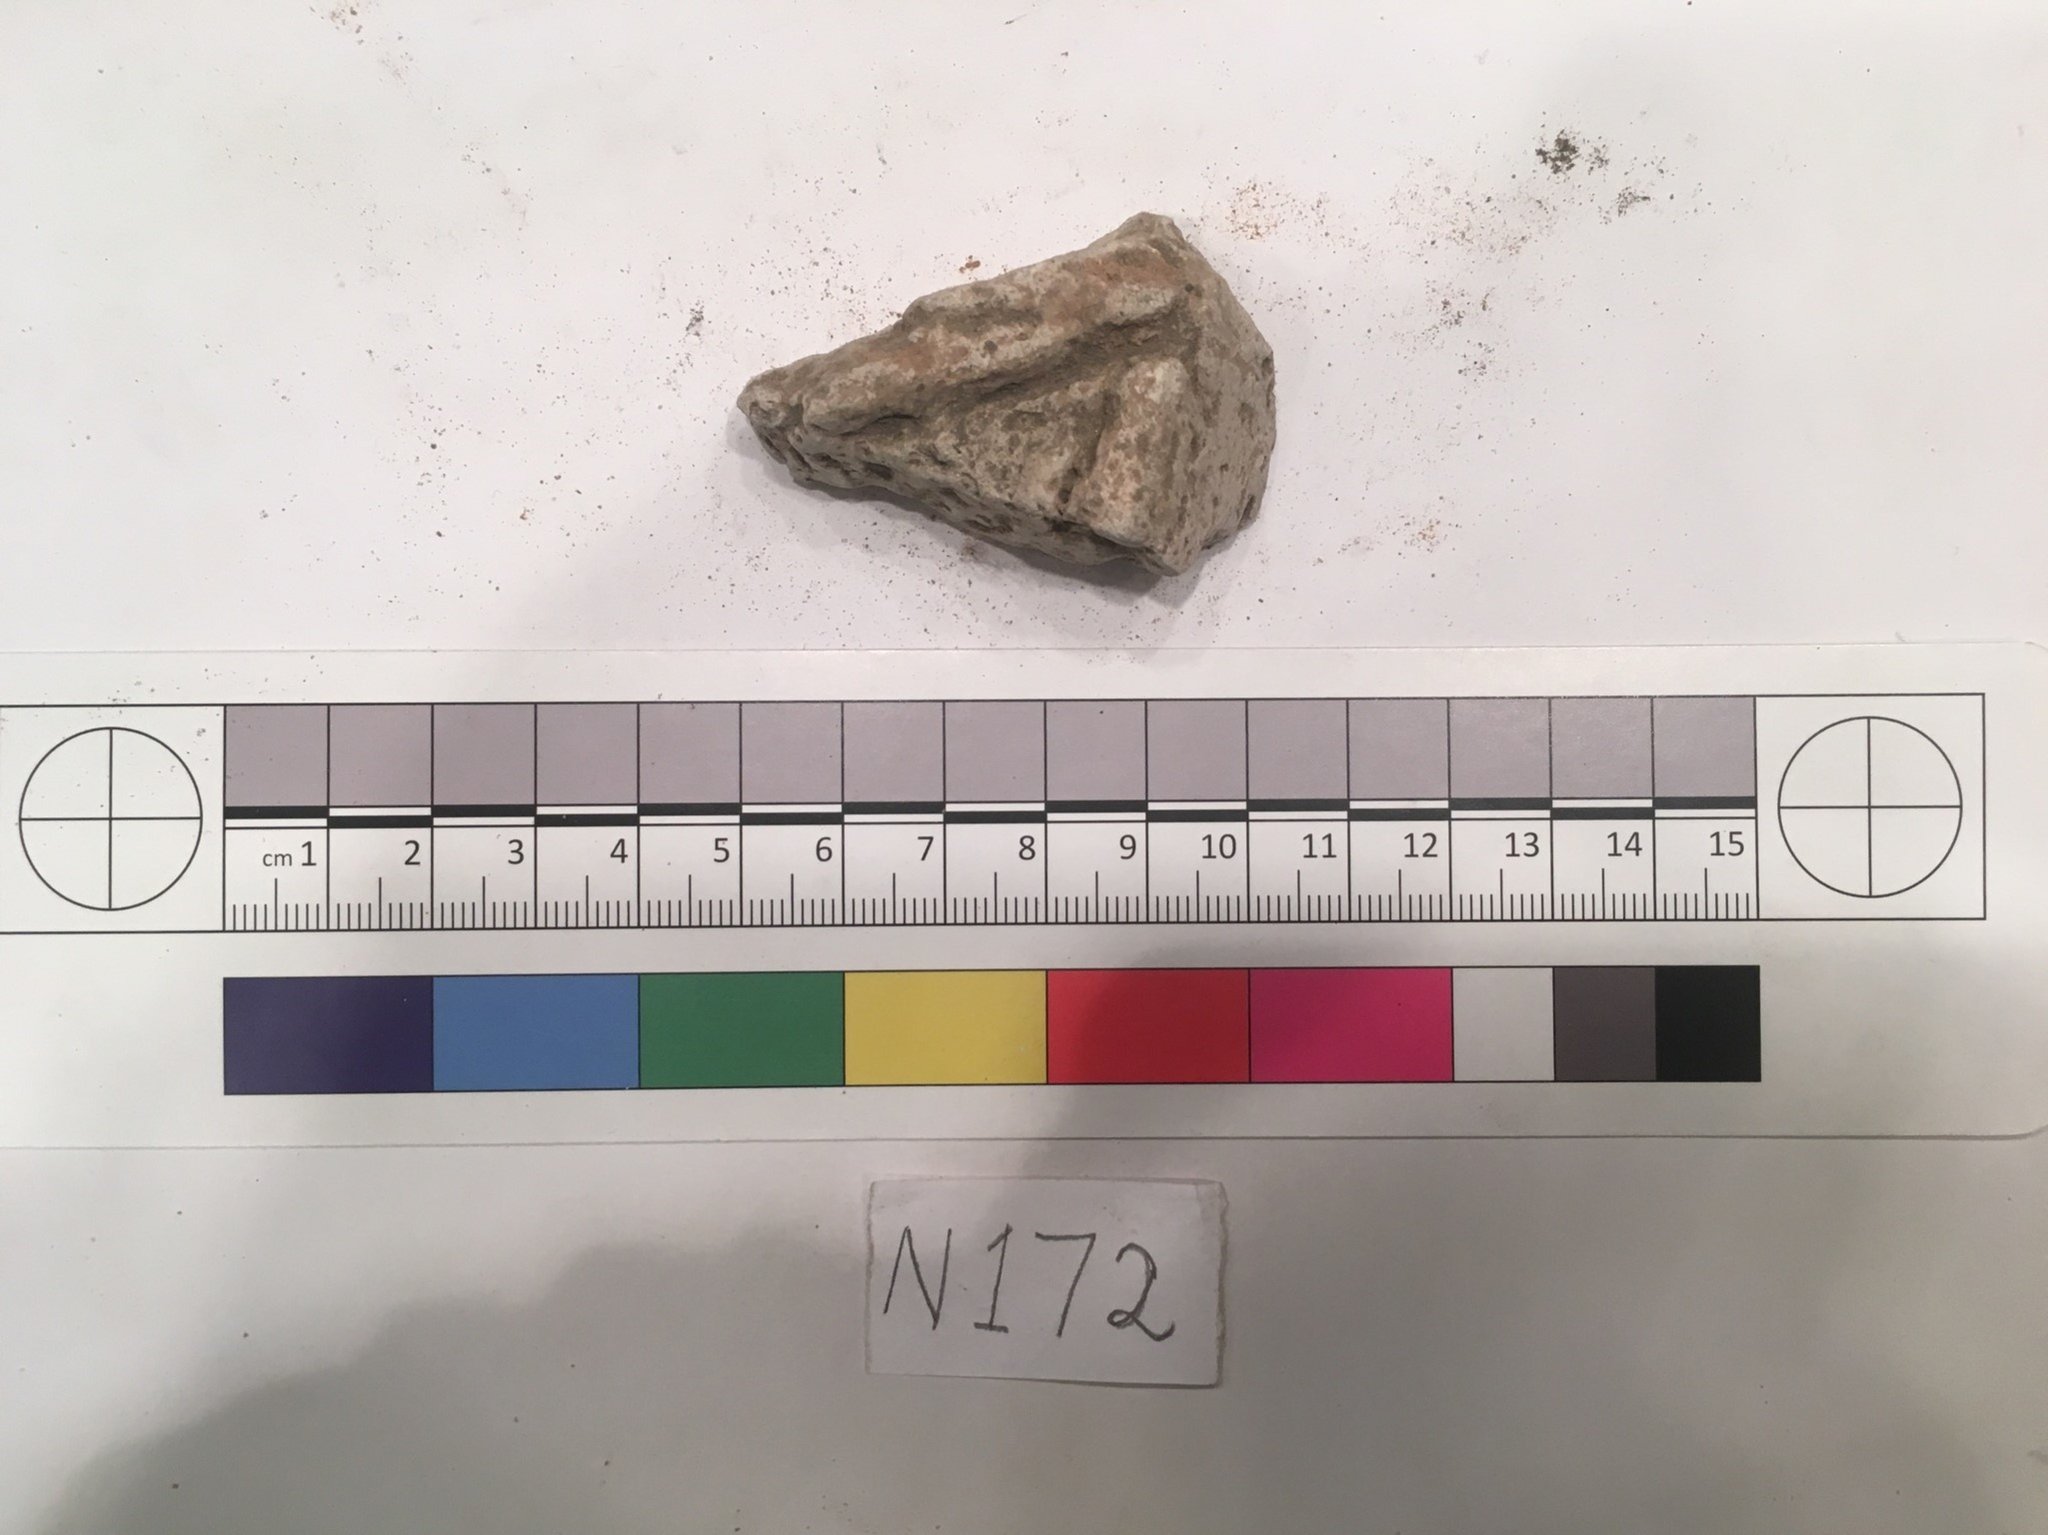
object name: fragment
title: Stucco Fragment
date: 701-1200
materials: plaster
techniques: carving, painting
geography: iran